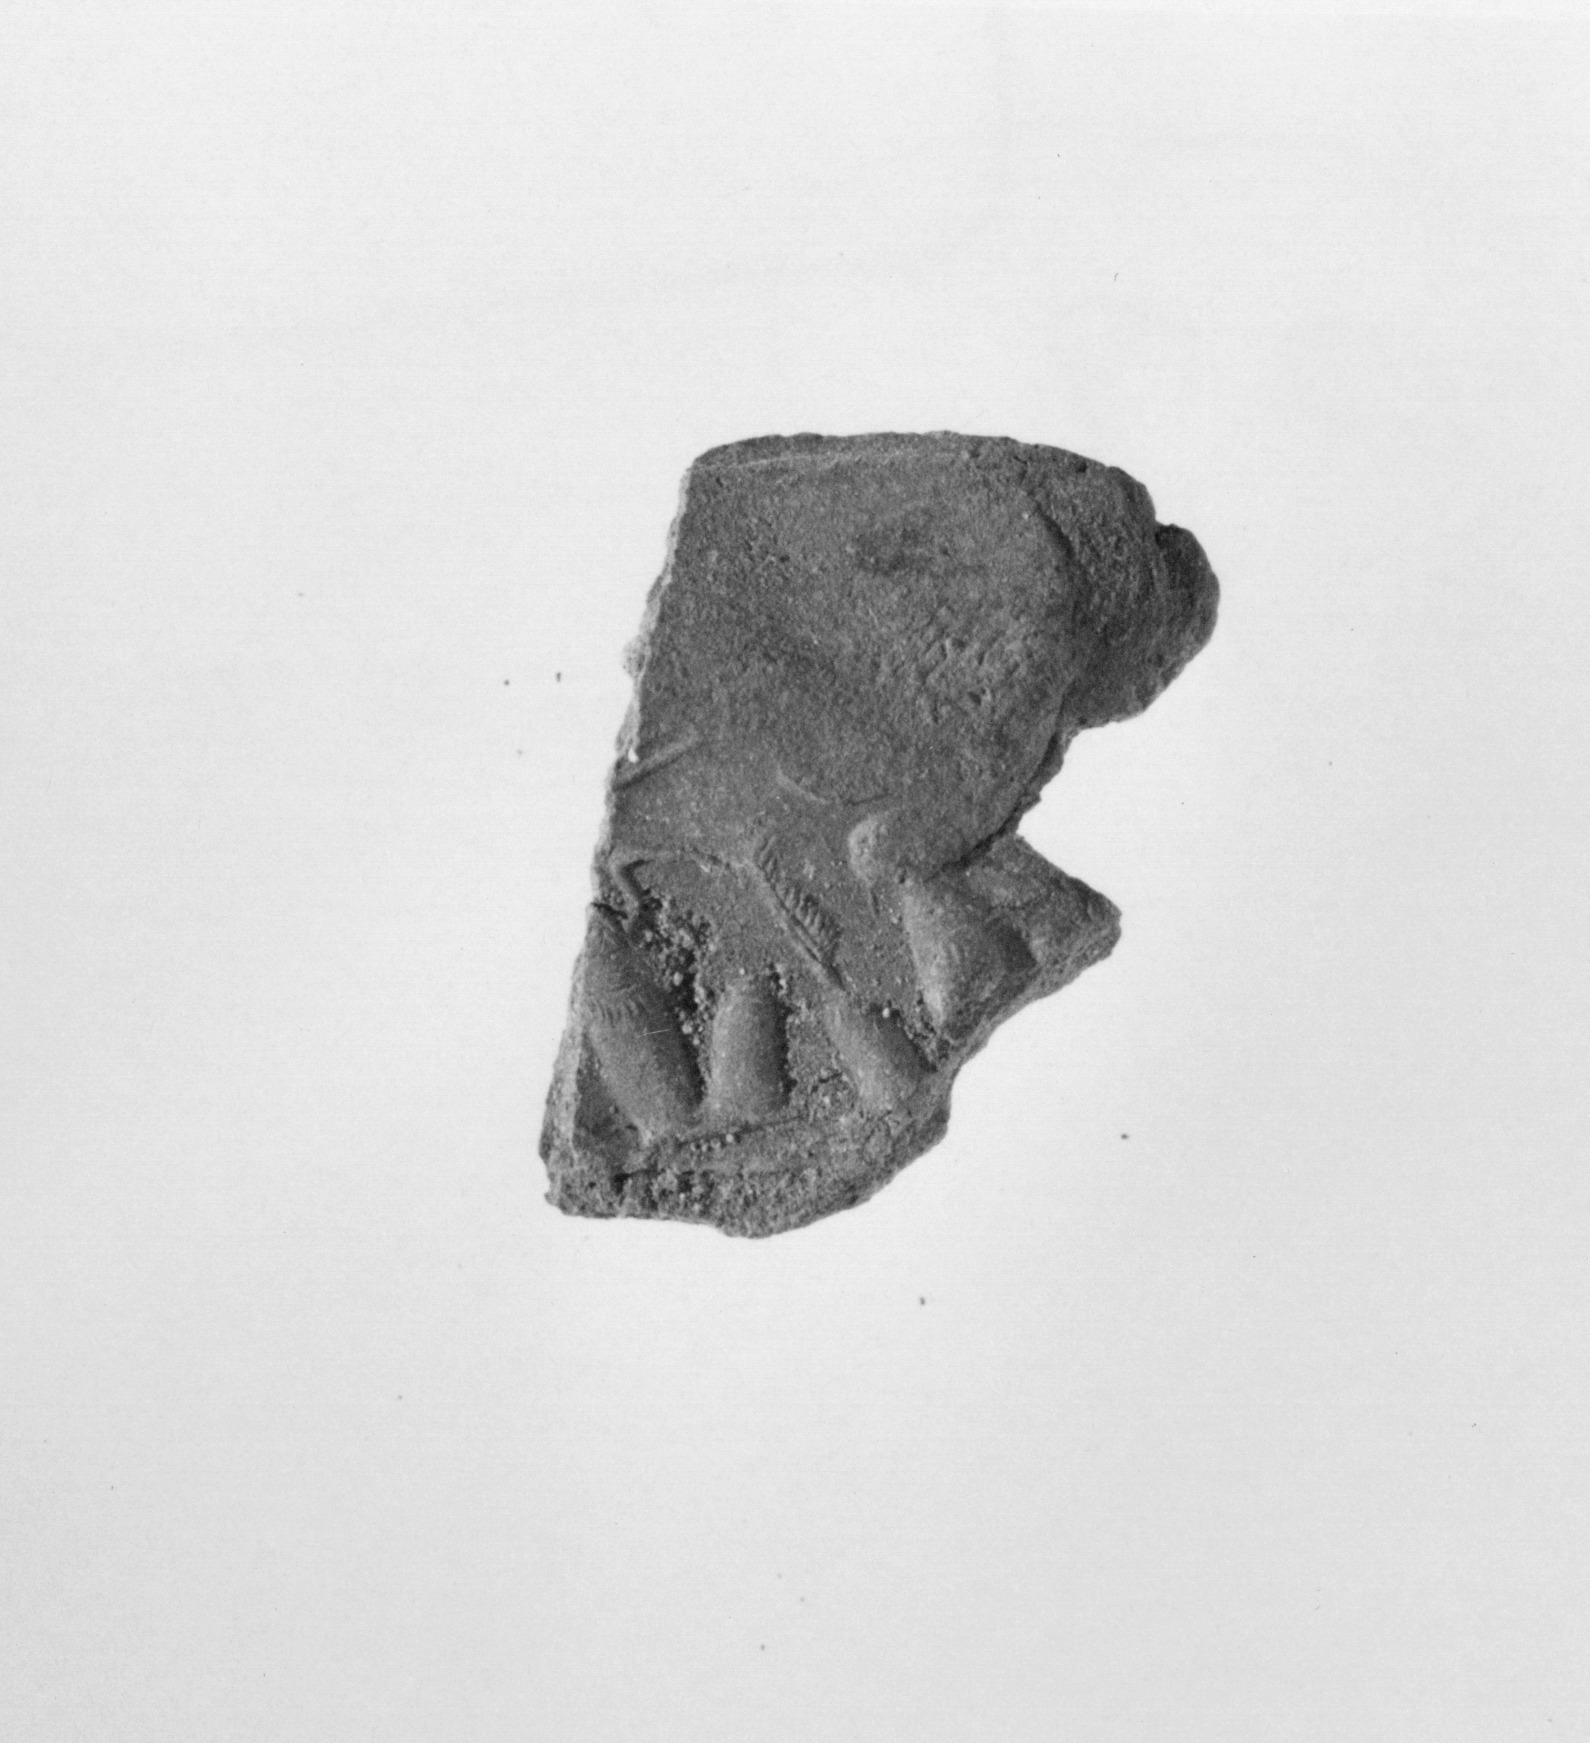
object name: sealing, nebmaatre, amenhotep iii, heb sed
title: Document Sealing With the Throne Name of Amenhotep III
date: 1390-1352 BCE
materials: mud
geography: egypt